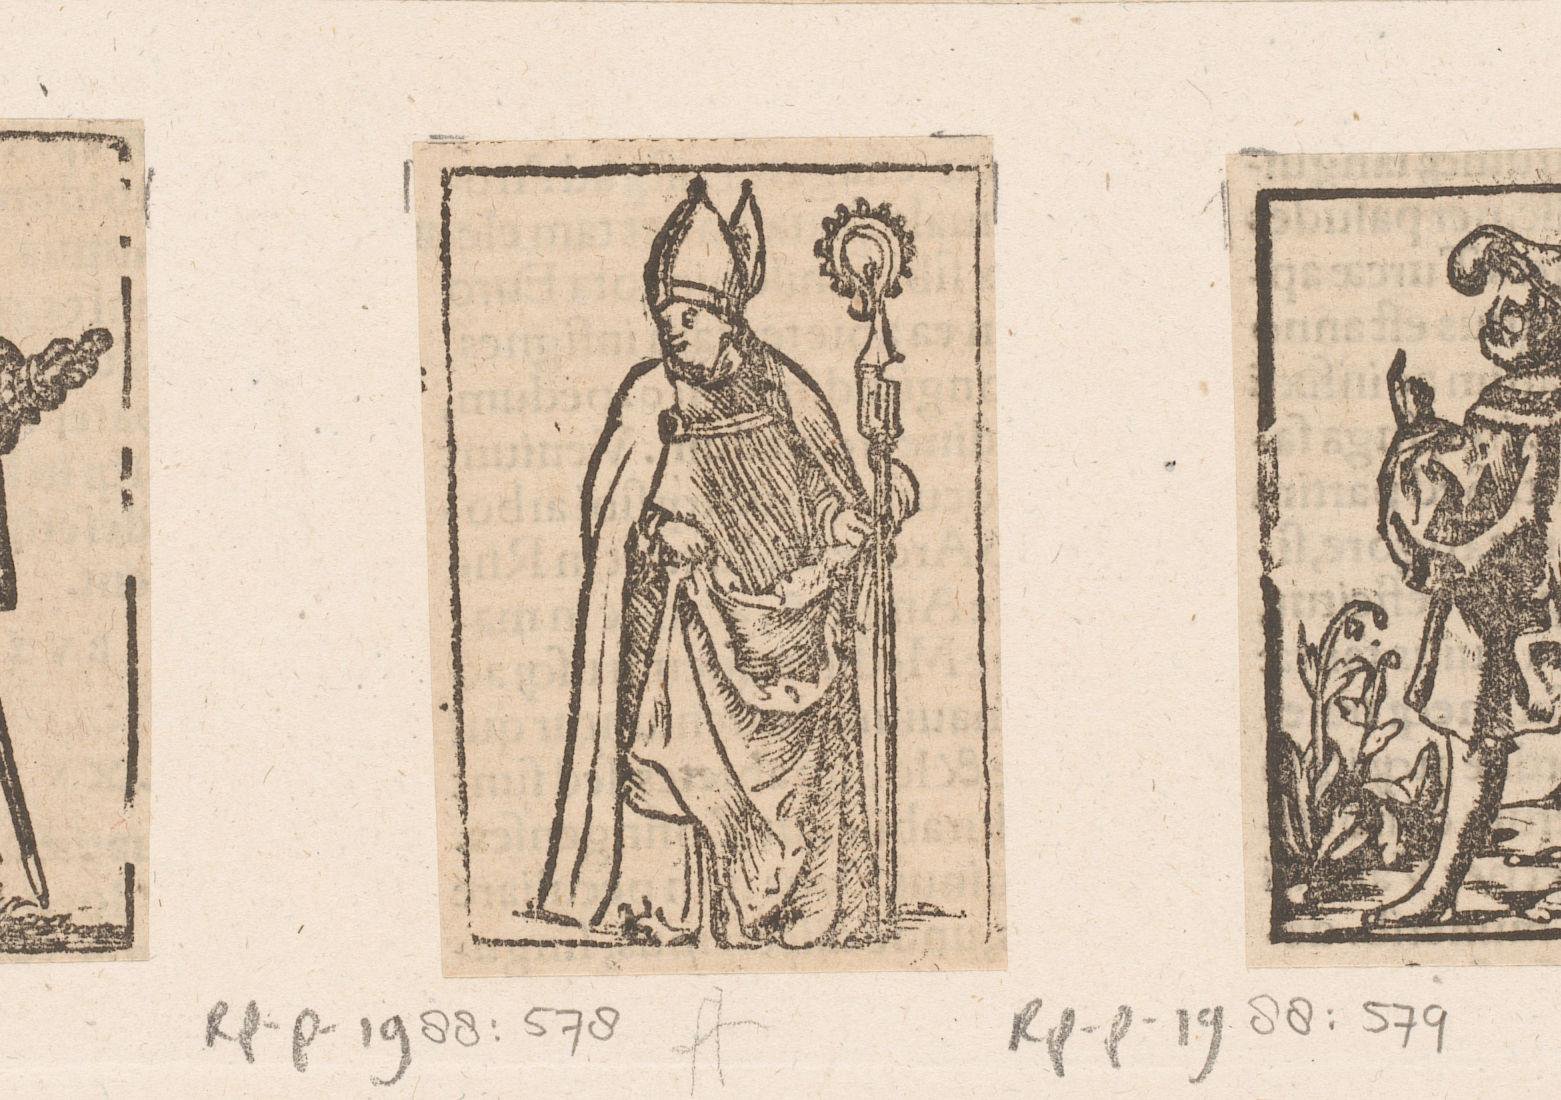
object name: book illustration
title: Bisschop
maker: Anonymous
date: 1500-1599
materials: paper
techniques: woodcut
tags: archbishop, bishop, etc. (roman catholic)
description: Prent afkomstig uit een onbekende publicatie.